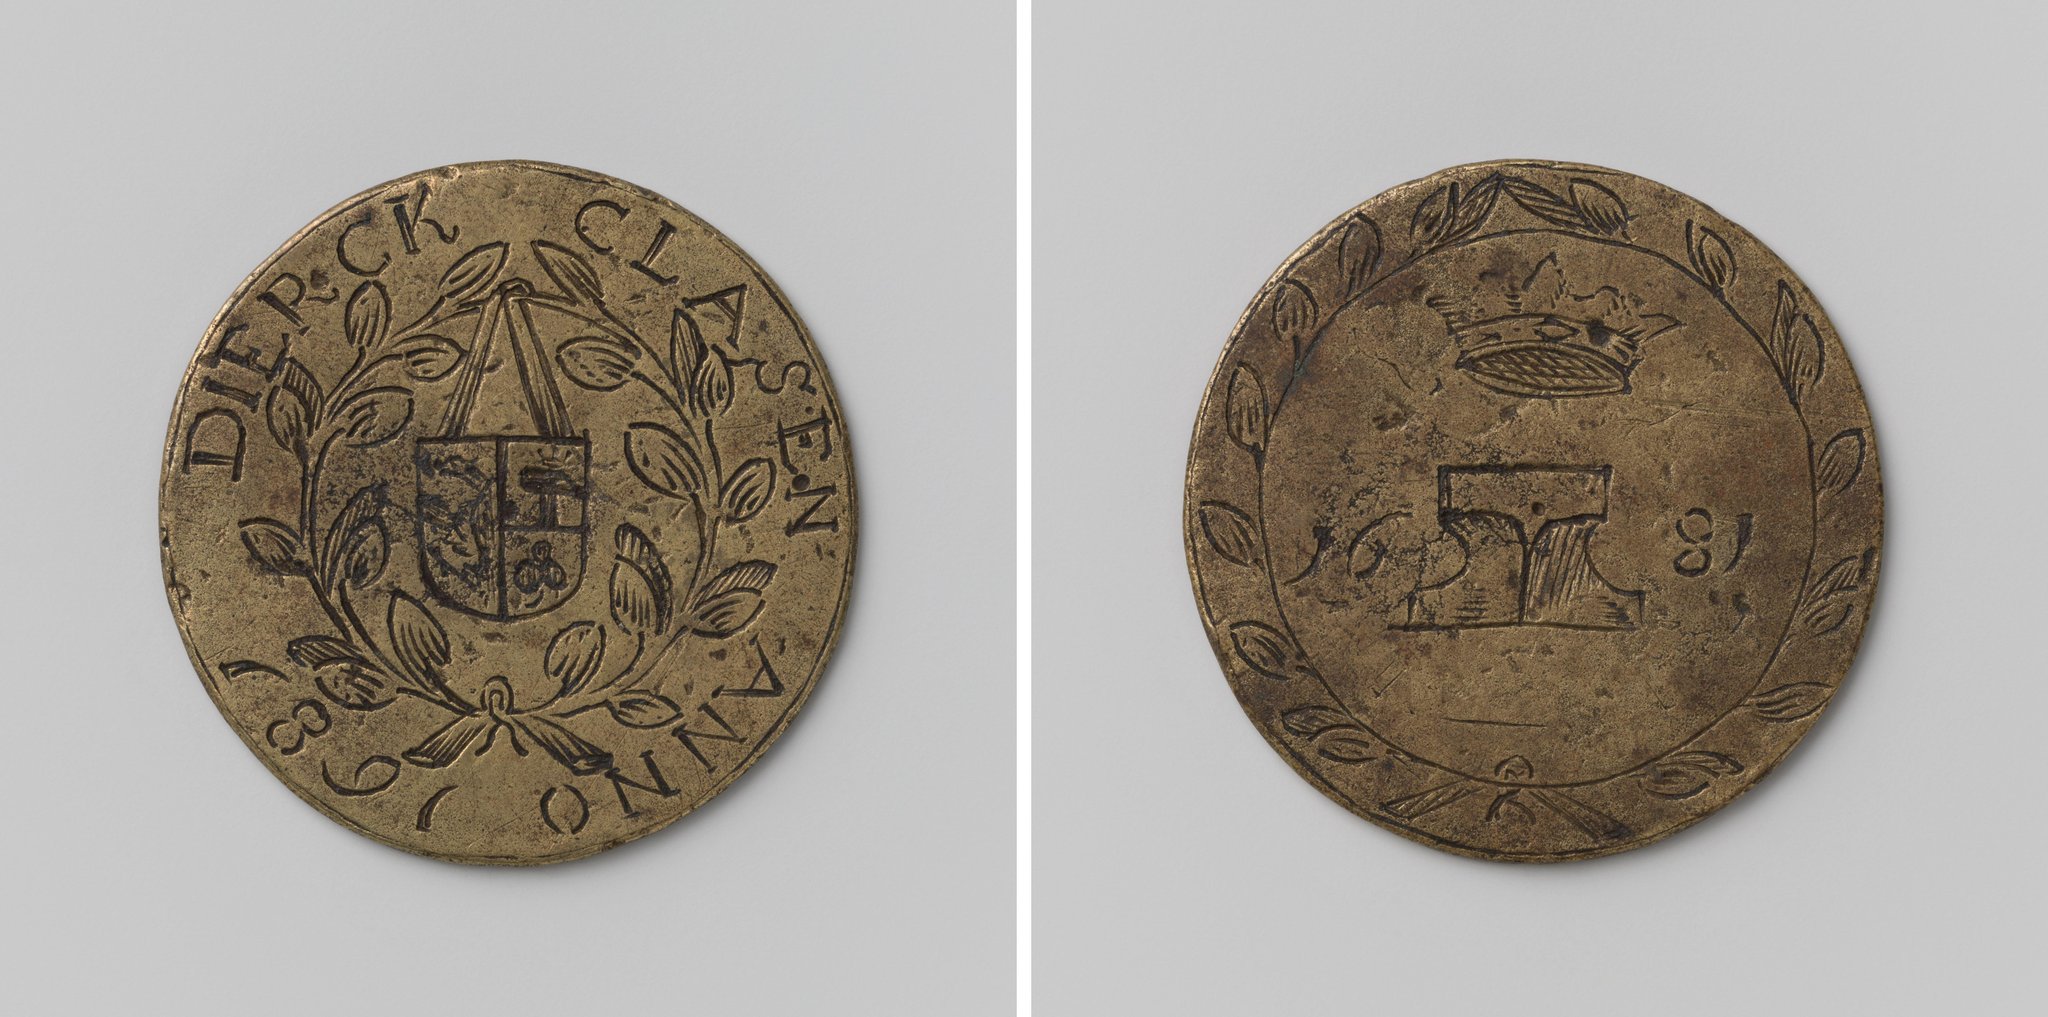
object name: medal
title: Gildepenning van het Smedengilde van een plaats in Friesland, op naam van Dierck Clasen.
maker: Anonymous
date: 1681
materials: brass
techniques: engraving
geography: friesland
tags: dierck clasen, friesland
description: Messing penning. Voorzijde: wapenschild, hangend aan krans binnen omschrift. Keerzijde: gekroond aambeeld tussen jaartal binnen omschrift